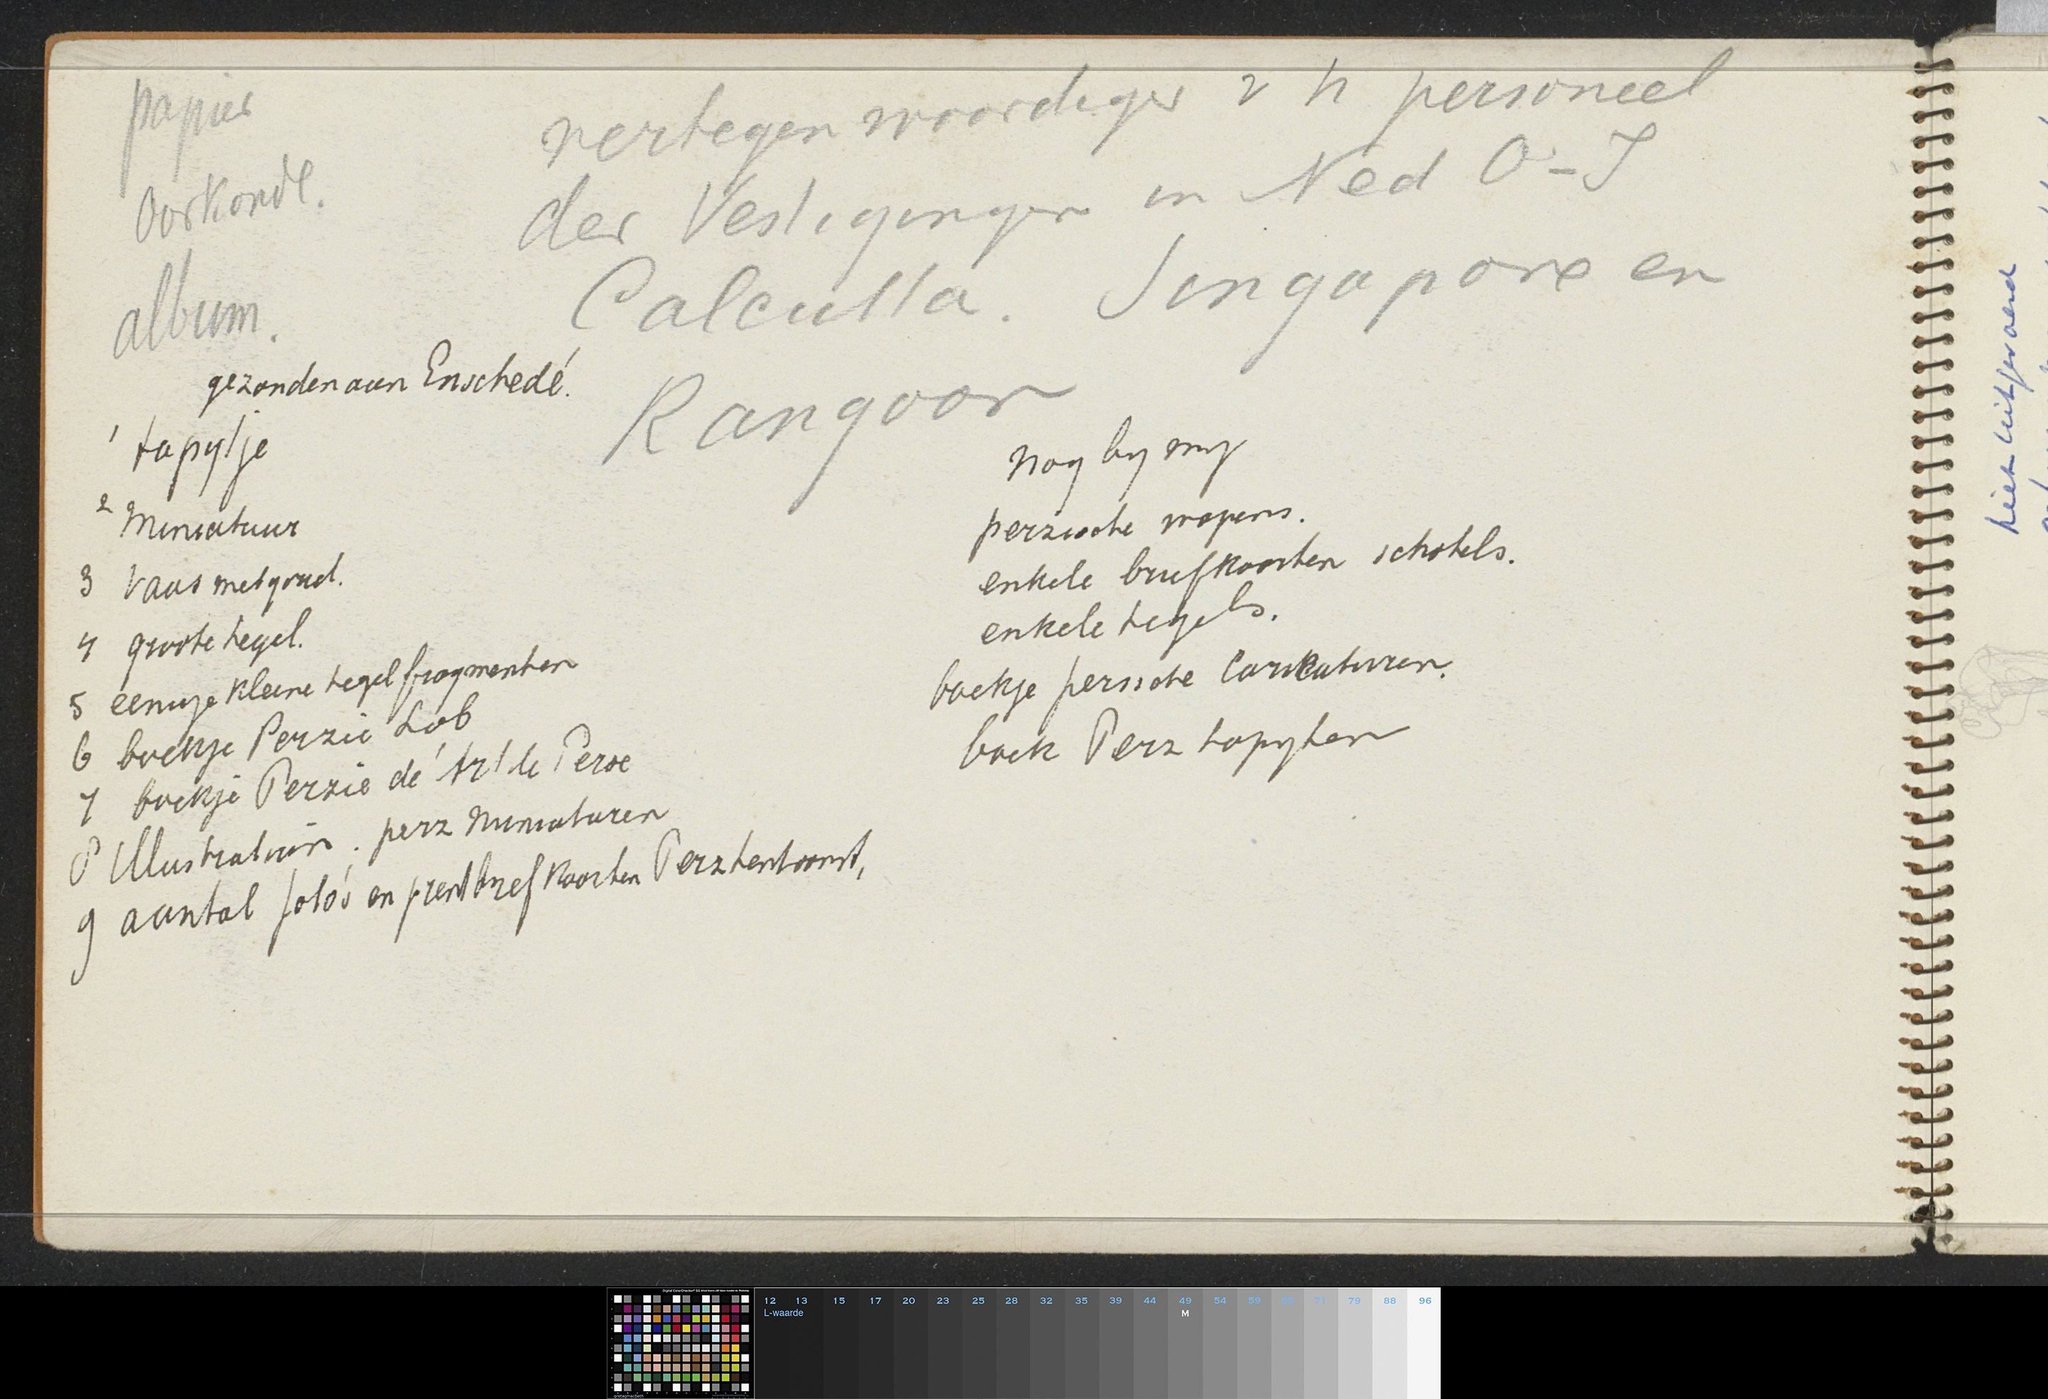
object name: sketchbook leaf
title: Notities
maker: carel adolph lion cachet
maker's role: draughtsman, print maker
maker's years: 1864-1945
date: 1930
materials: ink, paper, pencil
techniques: pen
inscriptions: annotation: ‘papier/ oorkonde/ album/ vertegenwoordigers v h personeel/ der Vestigingen in Ned O-I/ Calcutta Singapore en/ Rangoor/ gezonden aan Enschedé [...]’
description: Blad 1 verso uit een schetsboek met 20 bladen.